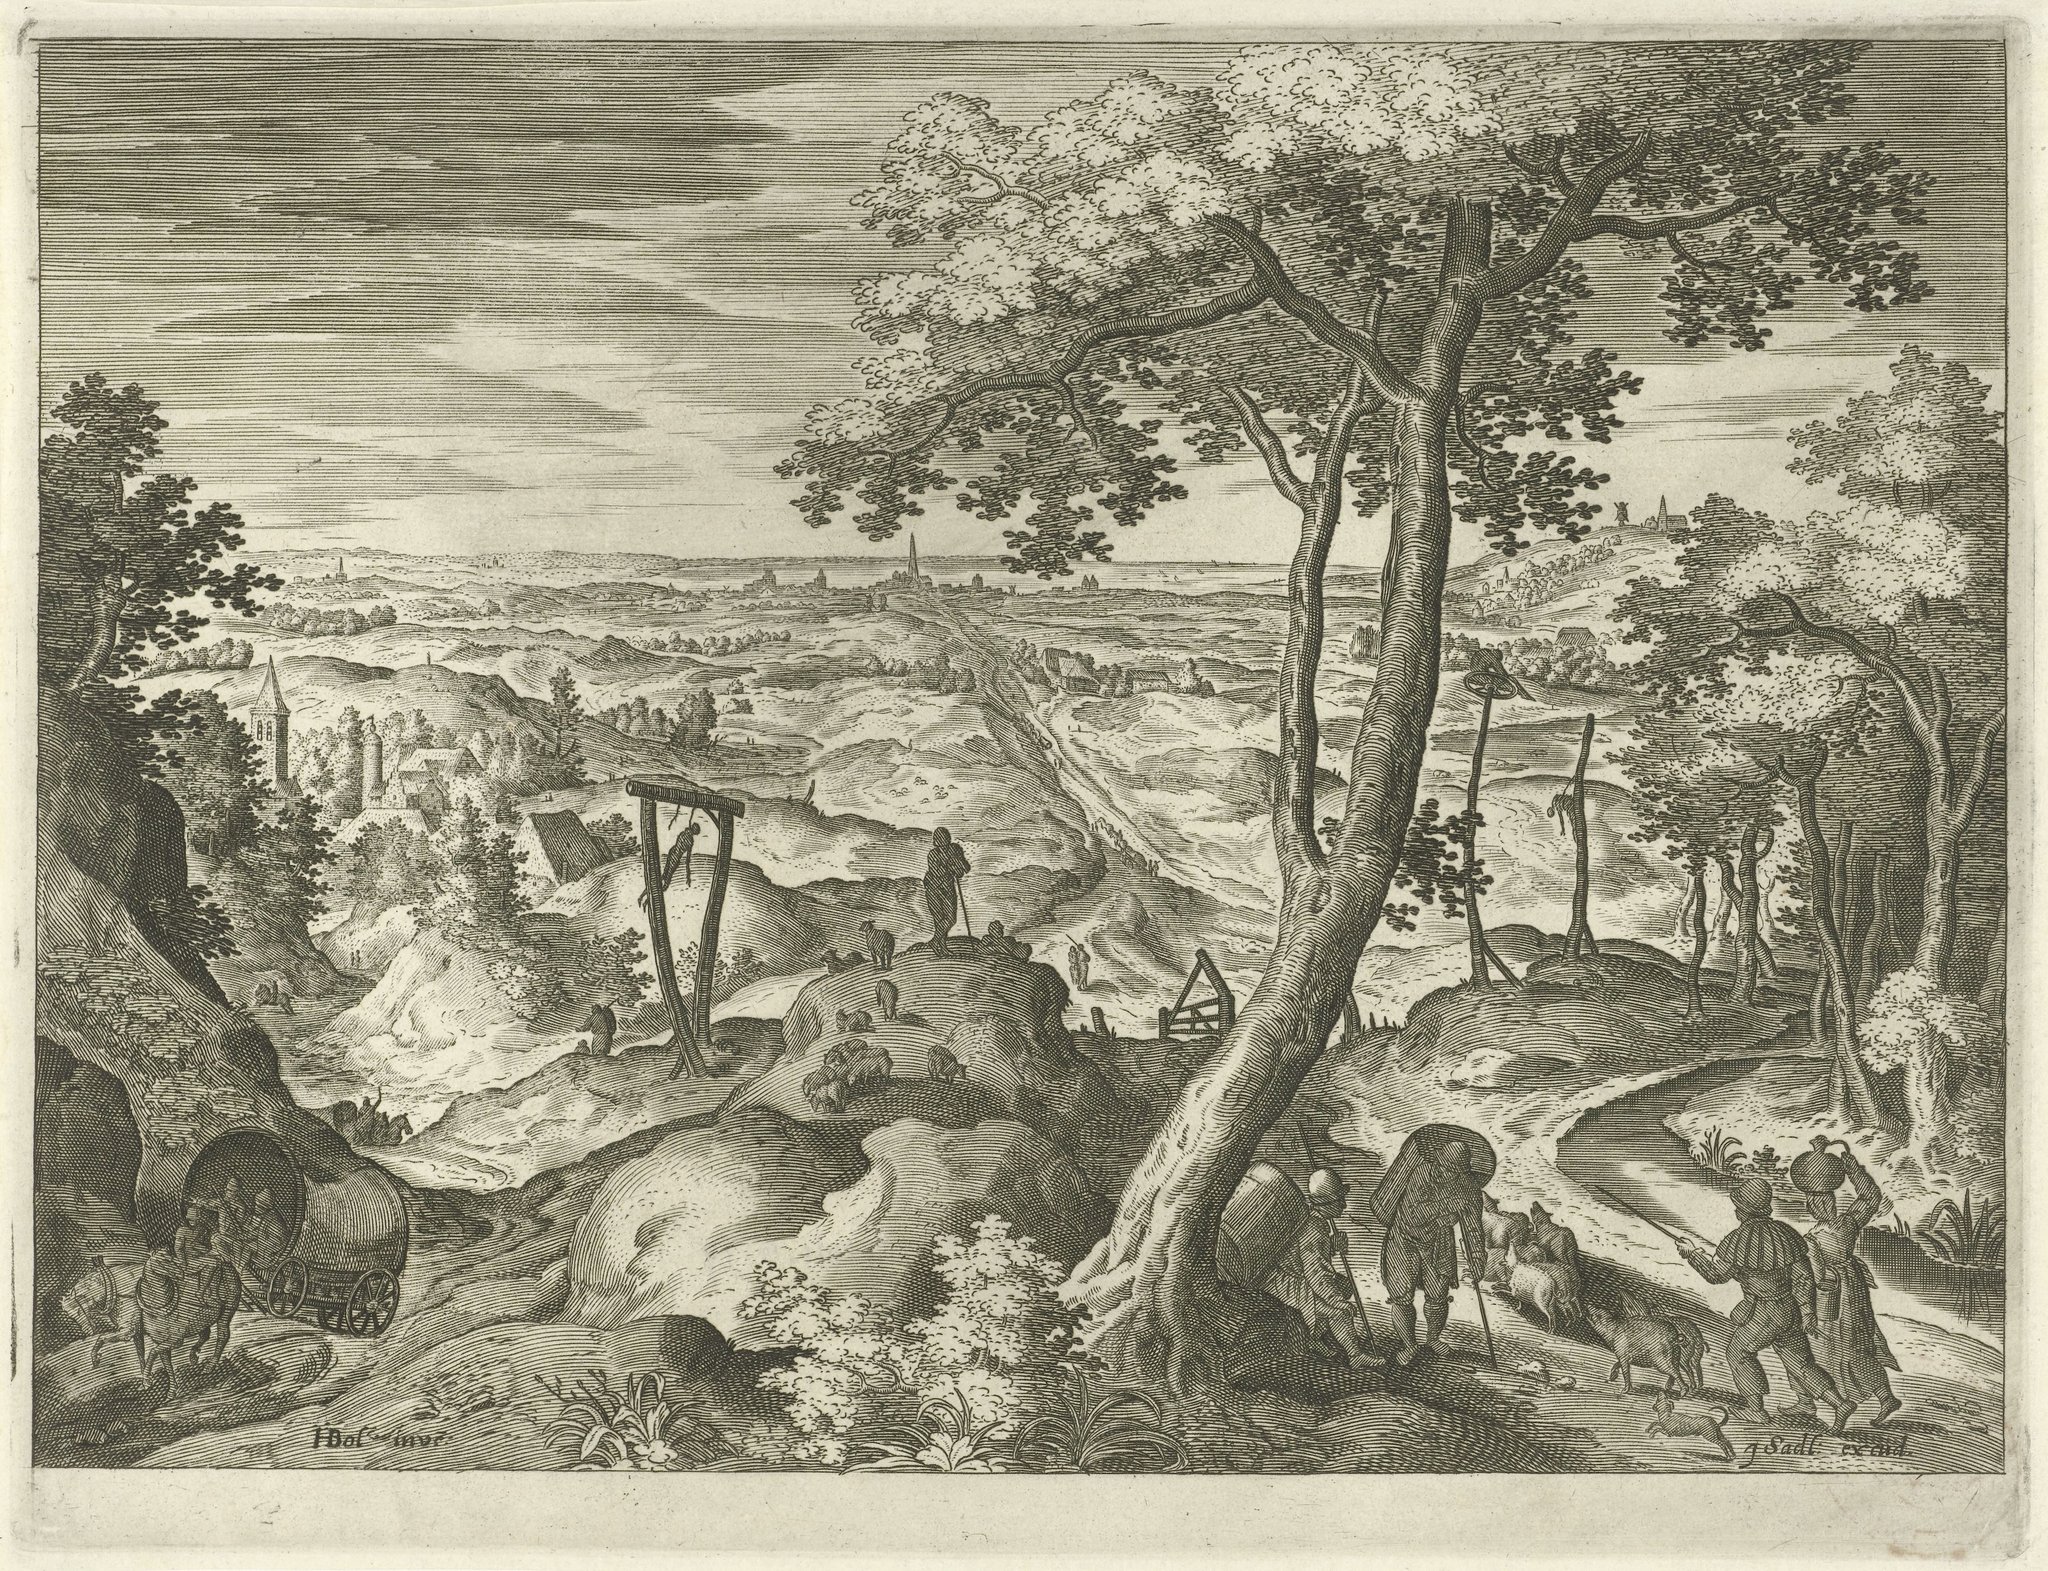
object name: print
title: Landschap met een galg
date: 1560-1600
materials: paper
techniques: engraving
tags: low hill country, death penalty, execution (+ place of execution), herding, herdsman, herdswoman, shepherd, shepherdess, cowherd, etc., violent death by hanging, covered wagon, hooded wagon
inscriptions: collector's mark: Lugt 240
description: Gezicht op een heuvelachtig landschap met in het midden een galg. Naast de galg een schaapherder met zijn kudde. Links op de voorgrond een huifkar getrokken door twee paarden. Rechts enkele reizigers. De prent maakt deel uit van een vierdelige serie met landschappen.